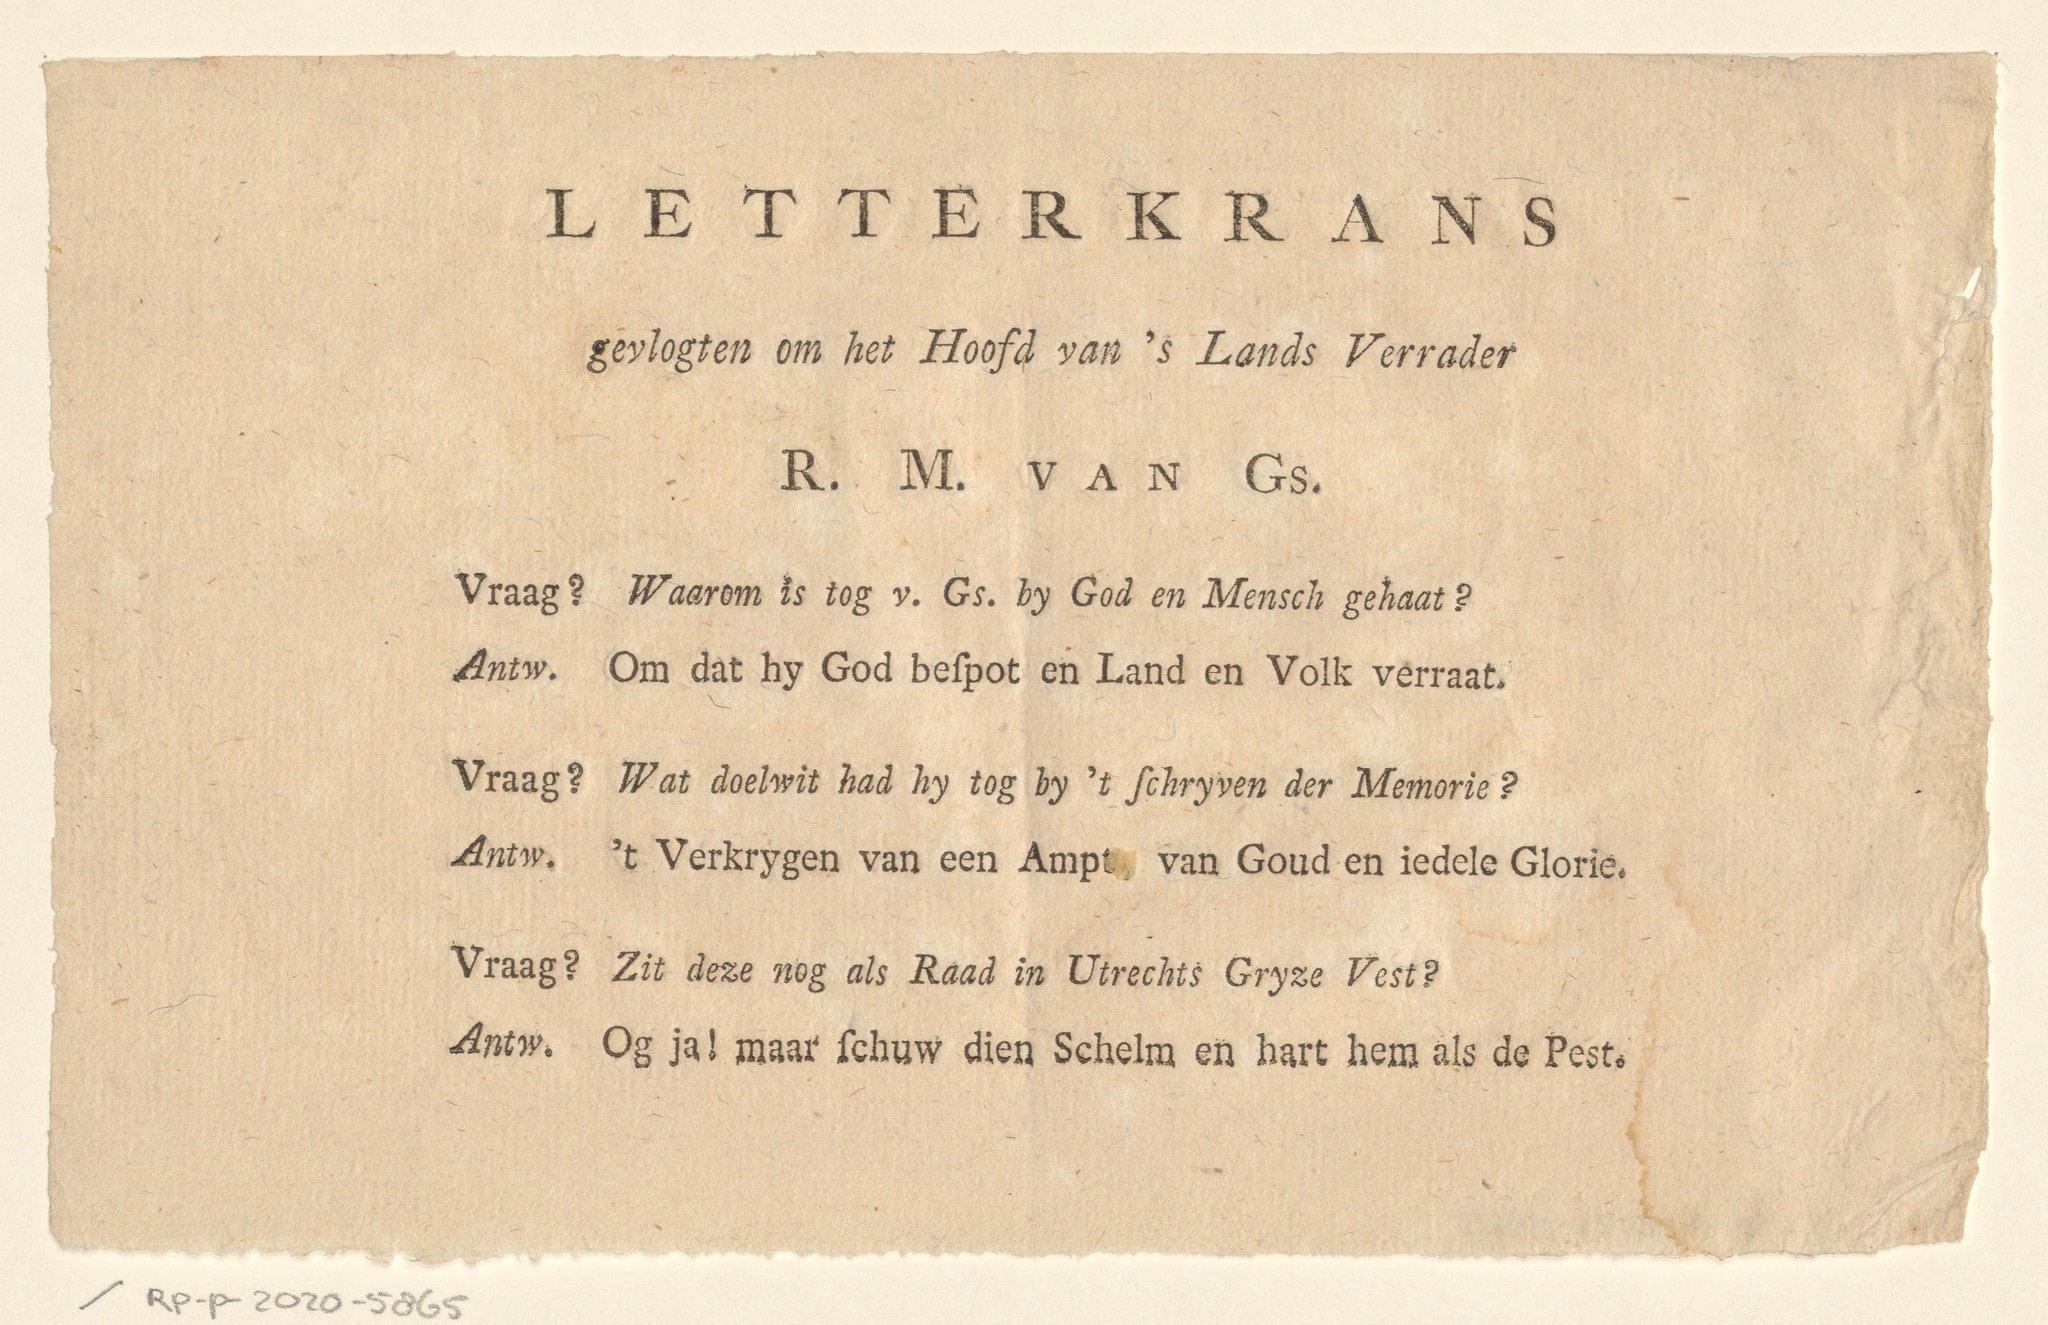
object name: text sheet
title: Hekeldicht op Rijklof Michaël van Goens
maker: monogrammist cp (schrijver) (18e eeuw)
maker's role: schrijver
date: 1782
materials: paper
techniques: letterpress printing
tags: historical persons, portrait of a writer, political caricatures and satires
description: Tekstblad bij: C.P., Le Voici. Of pourtrait en byzonderheeden, aangaande den politiek-vertoog-schryver, Ryklof Michaël van Goens. S.l.s.n., 1782, vermeld op p. 42.